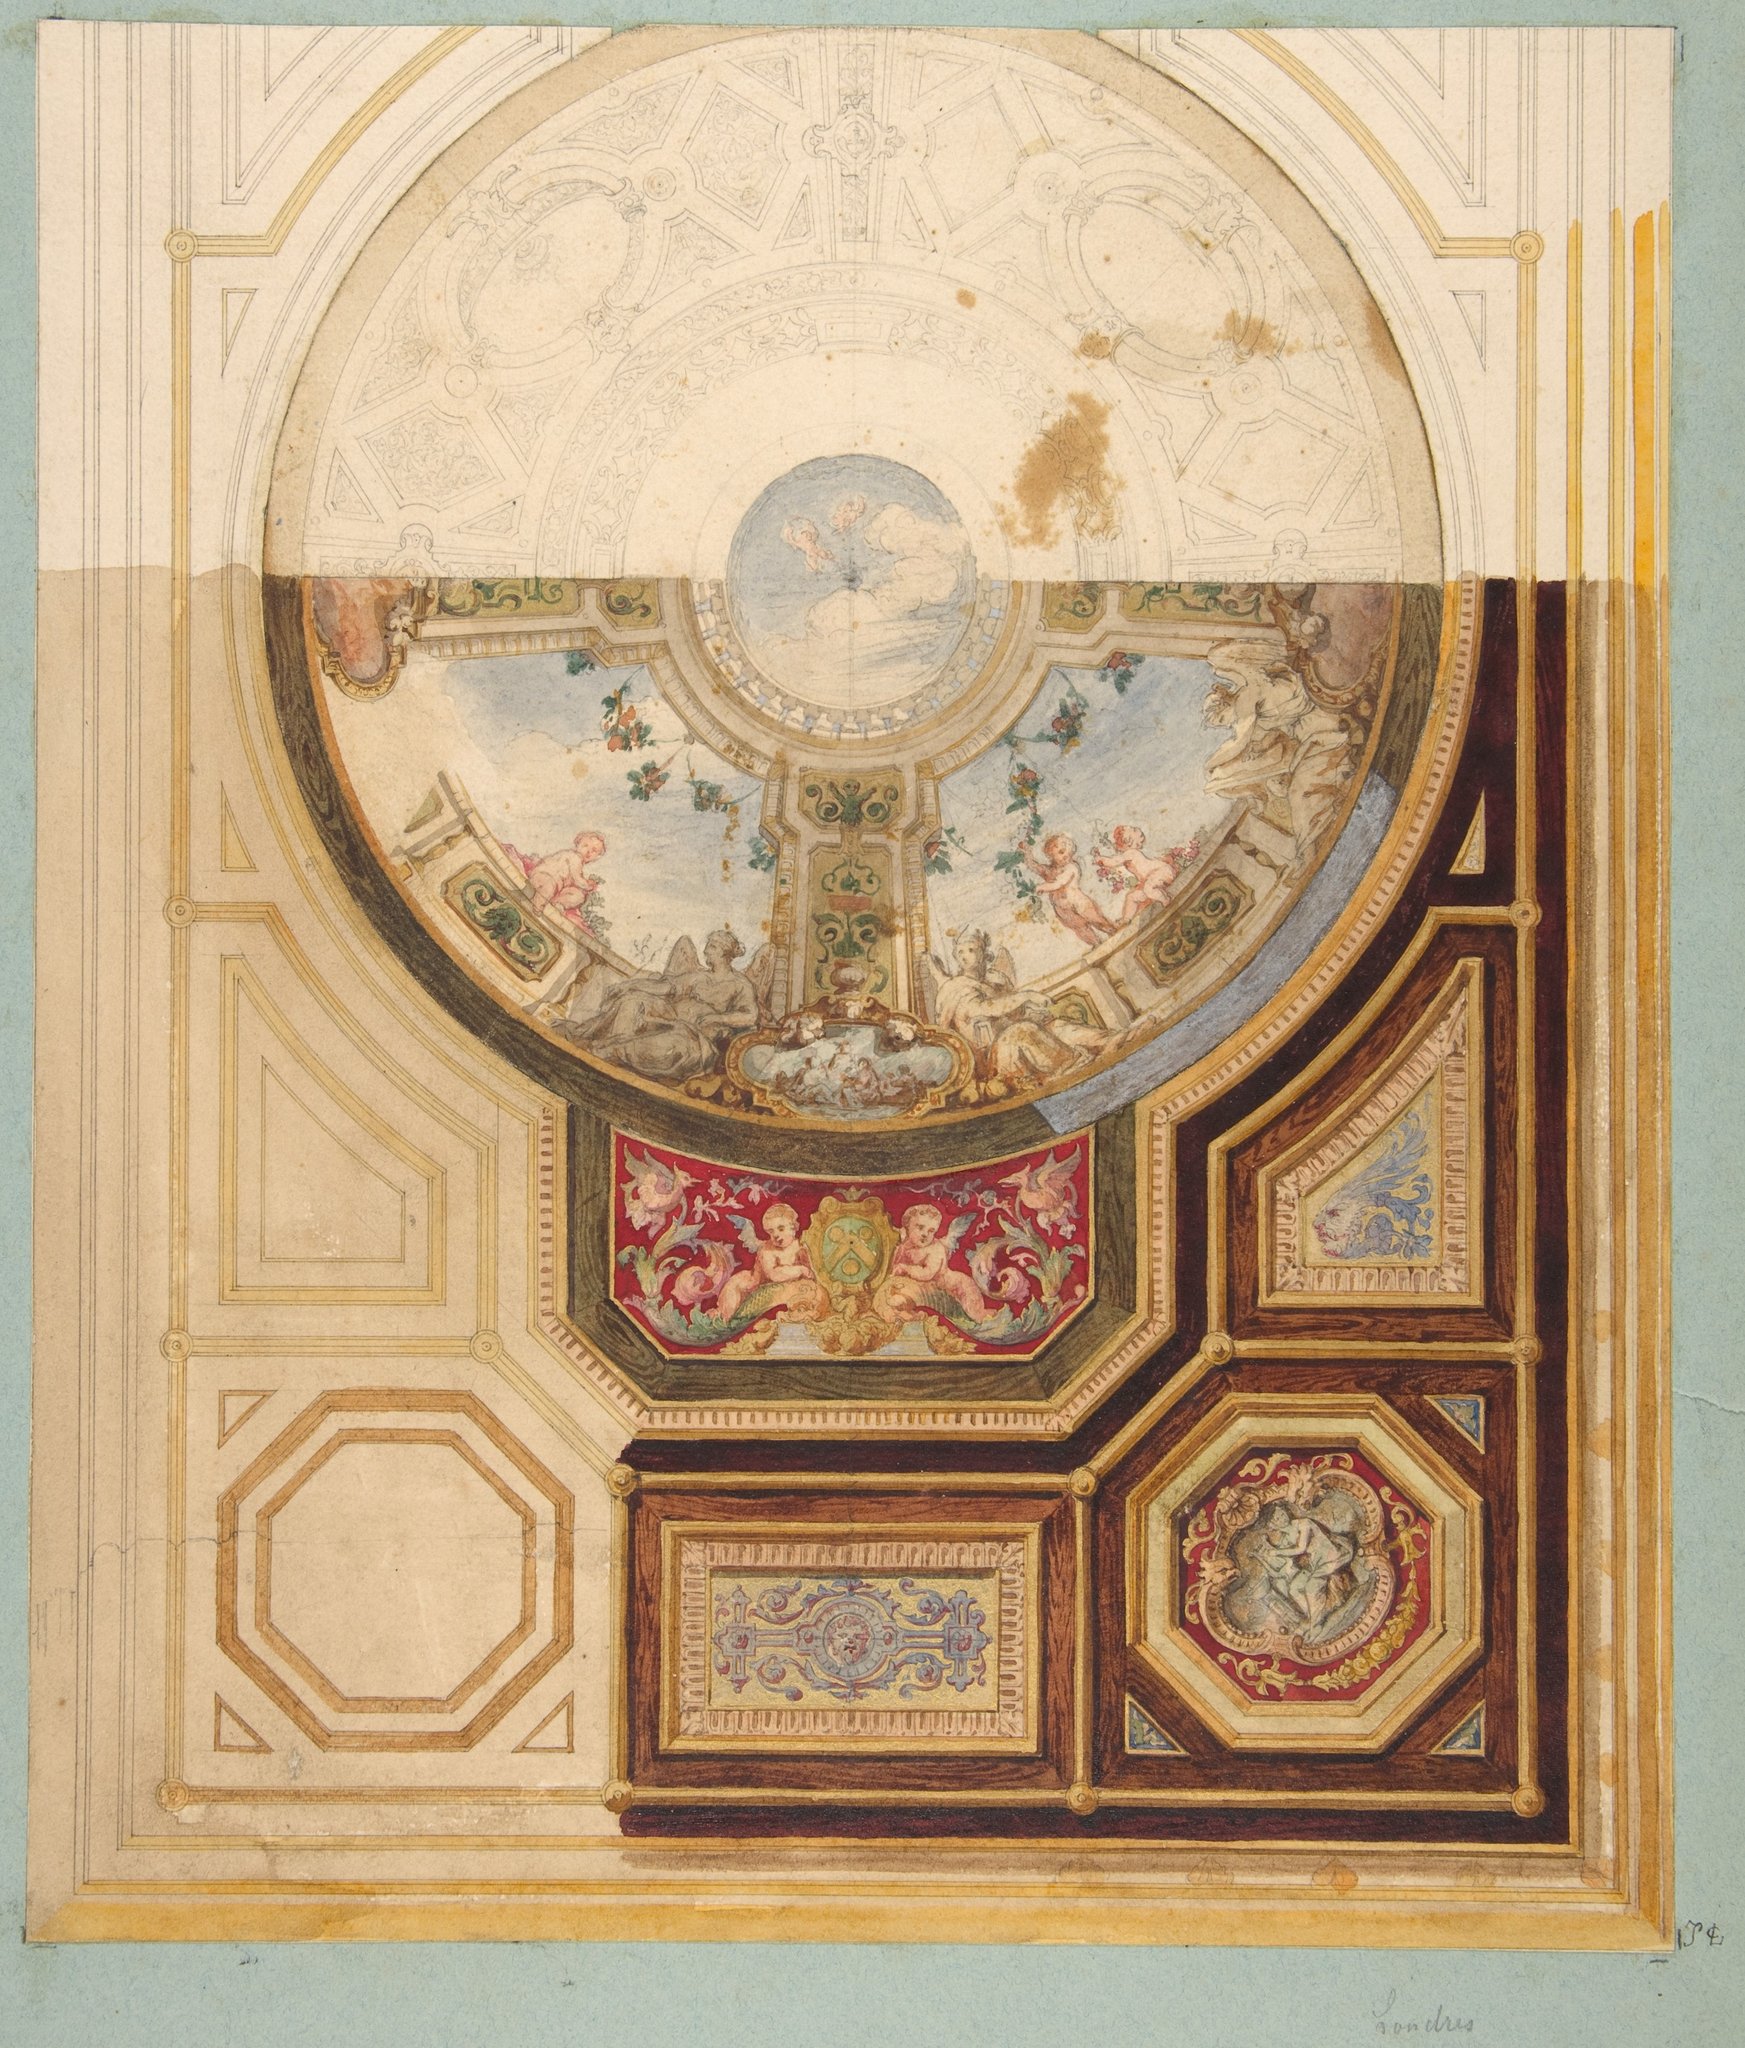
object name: drawing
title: Design for a paneled ceiling with a trompe l'oeil dome in London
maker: jules-edmond-charles lachaise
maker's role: artist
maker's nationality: french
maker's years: 1897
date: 1801-1900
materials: gold paint, graphite, watercolor